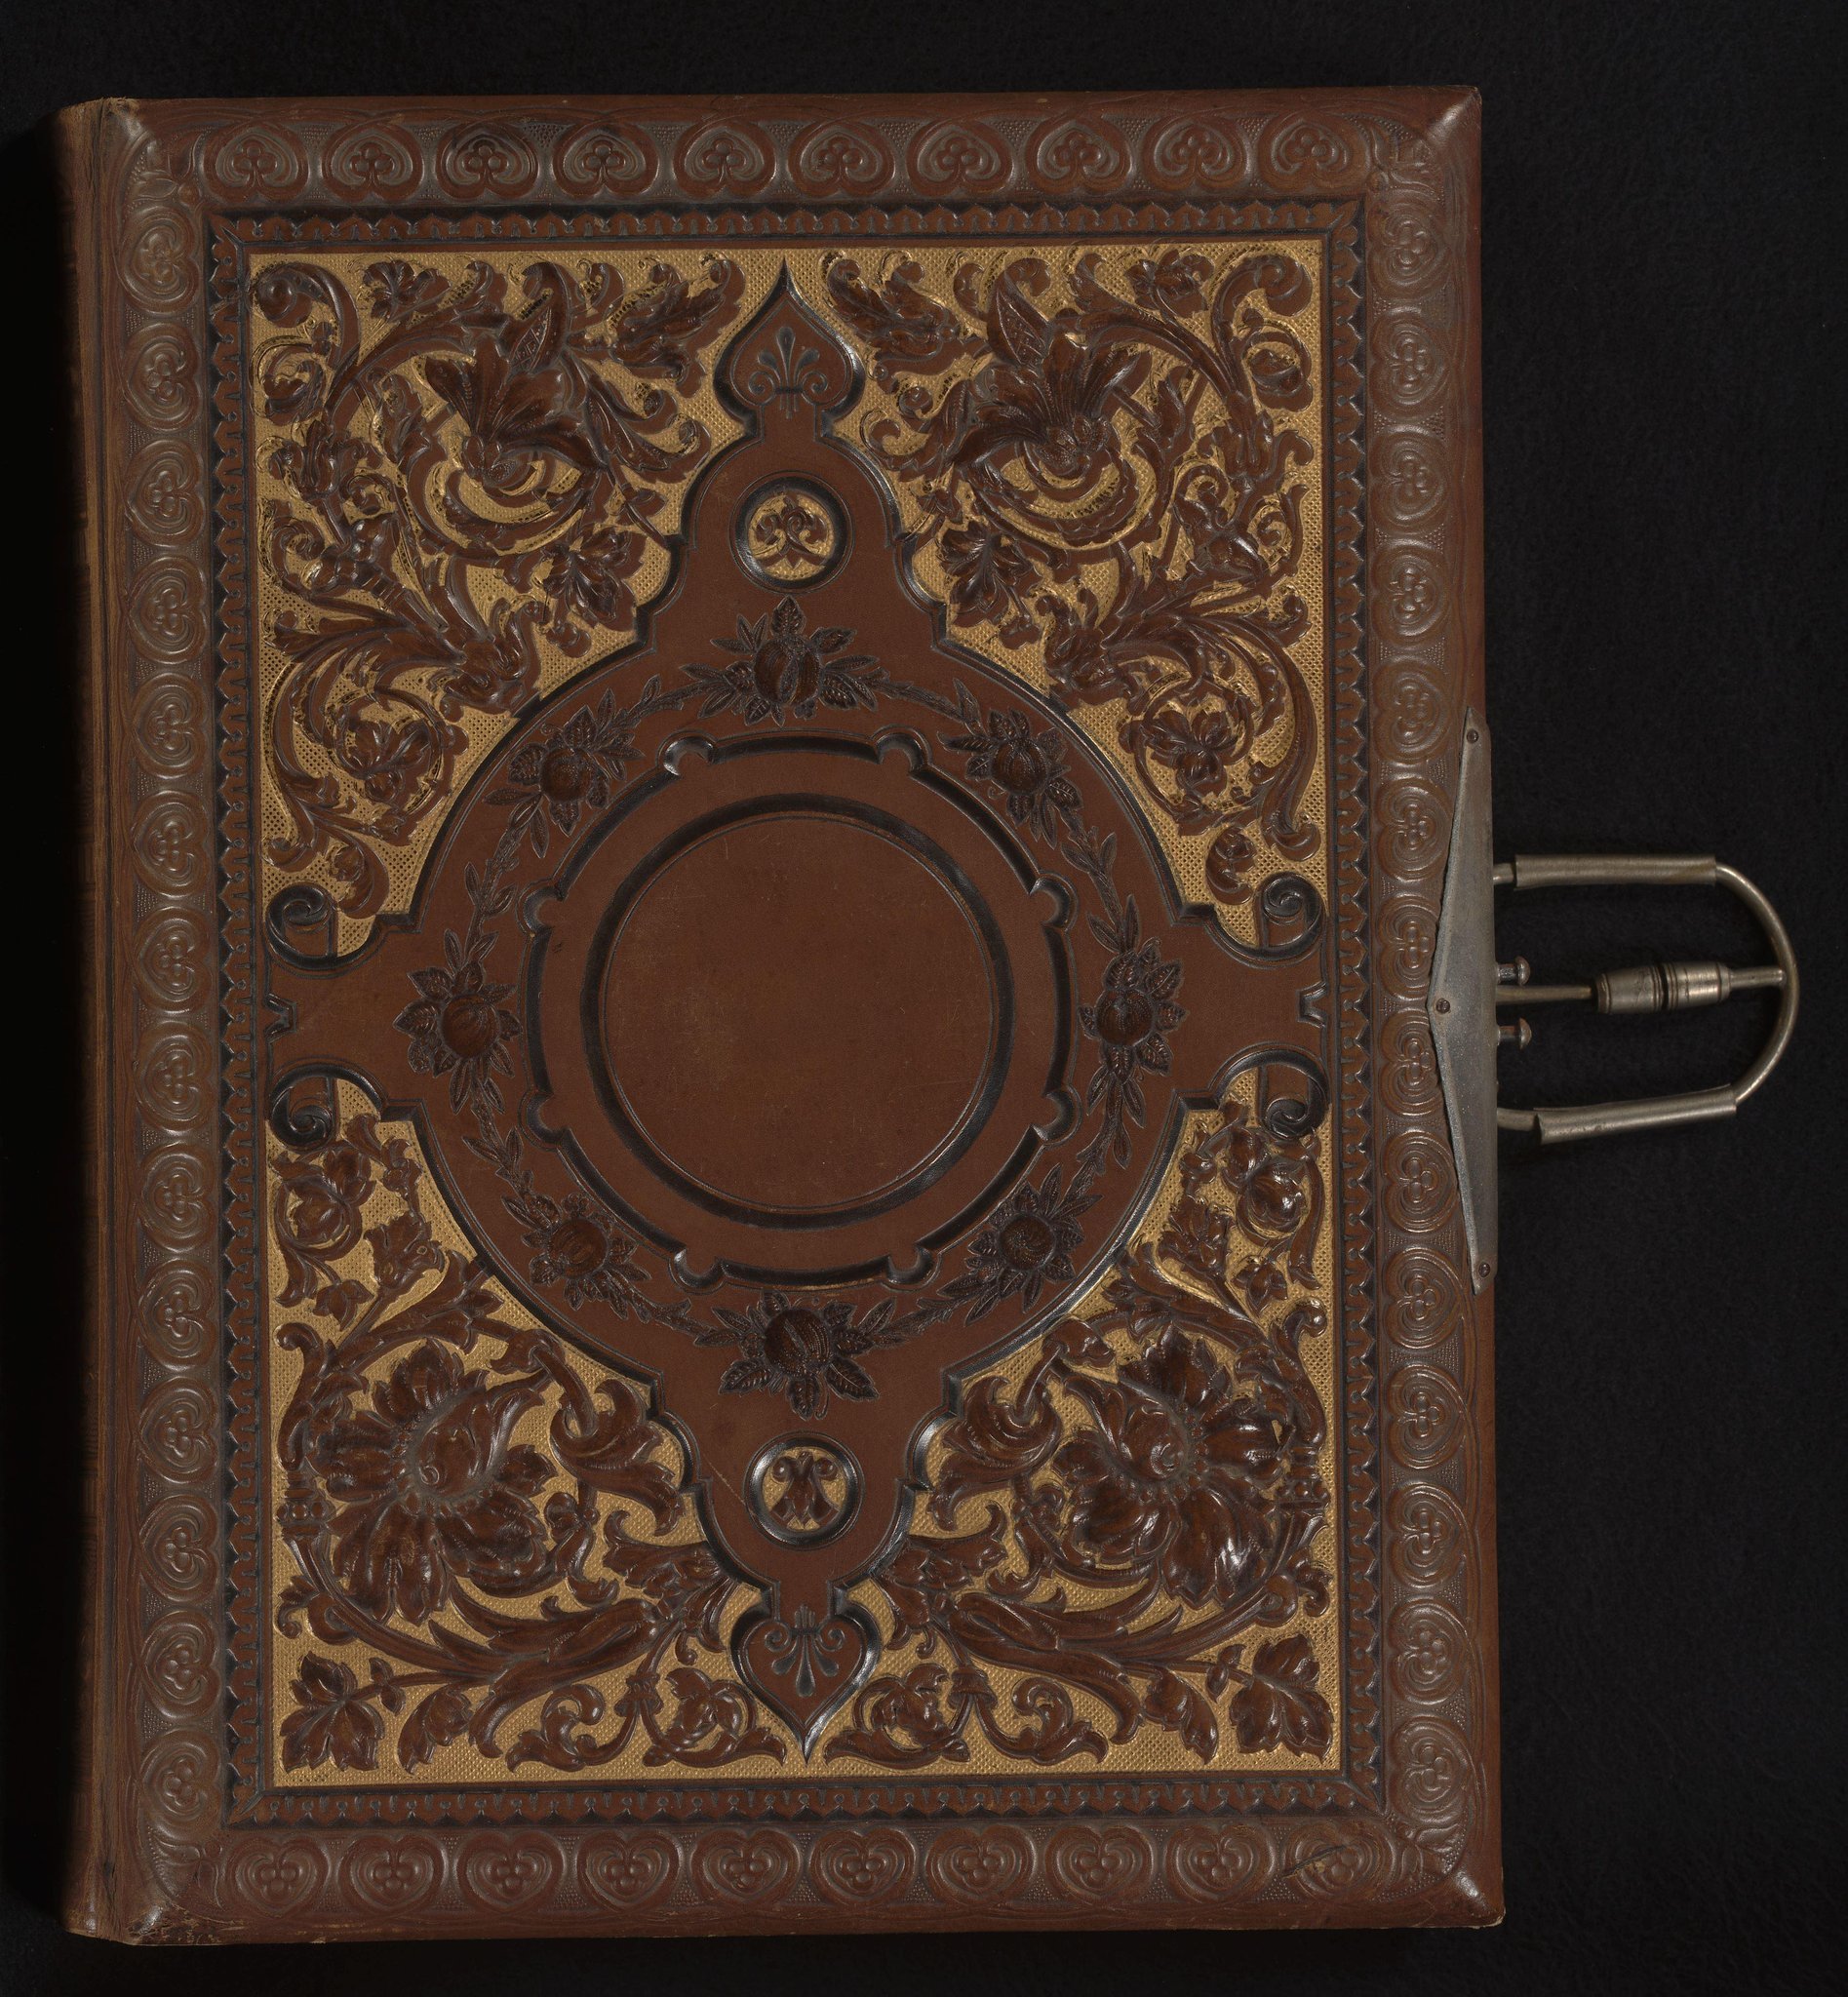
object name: photograph album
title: Nederlands fotoalbum met 65 portretten en een fotoreproductie van een tekening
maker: Anonymous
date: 1875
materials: cardboard, leather, metal, paper, photographic support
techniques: albumen print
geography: netherlands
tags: (scenes from the life of) john the baptist and mary, theologian, historical persons - bb - woman, child, historical persons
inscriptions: collector's mark: ‘DIENST/ VERSPREIDE/ RIJKSKOLLEKTIES/ (...) A 825’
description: Fotoalbum met 36 pagina's met in totaal 66 foto's. Het album bevat 57 cartes-de-visite en 8 kabinetfoto's in met gouden lijnen of bloemdecoraties omkaderde passe-partouts en een losse foto van groter formaat. Niet alle passe-partouts in het album zijn gevuld. Afgebeeld zijn portretten van onbekende mannen, vrouwen en kinderen. Een deel van de geportretteerden is geestelijke. Daarnaast bevat het album een fotoreproductie van een tekening. De foto's zijn gemaakt door diverse Nederlandse fotografen, waaronder de gebroeders Cordes, J.G. Mulder en Johannes Wilhelmus Franciscus Offenberg. Het merendeel van de foto's is gemaakt in Haarlem. Van 4 foto's is de fotograaf anoniem.